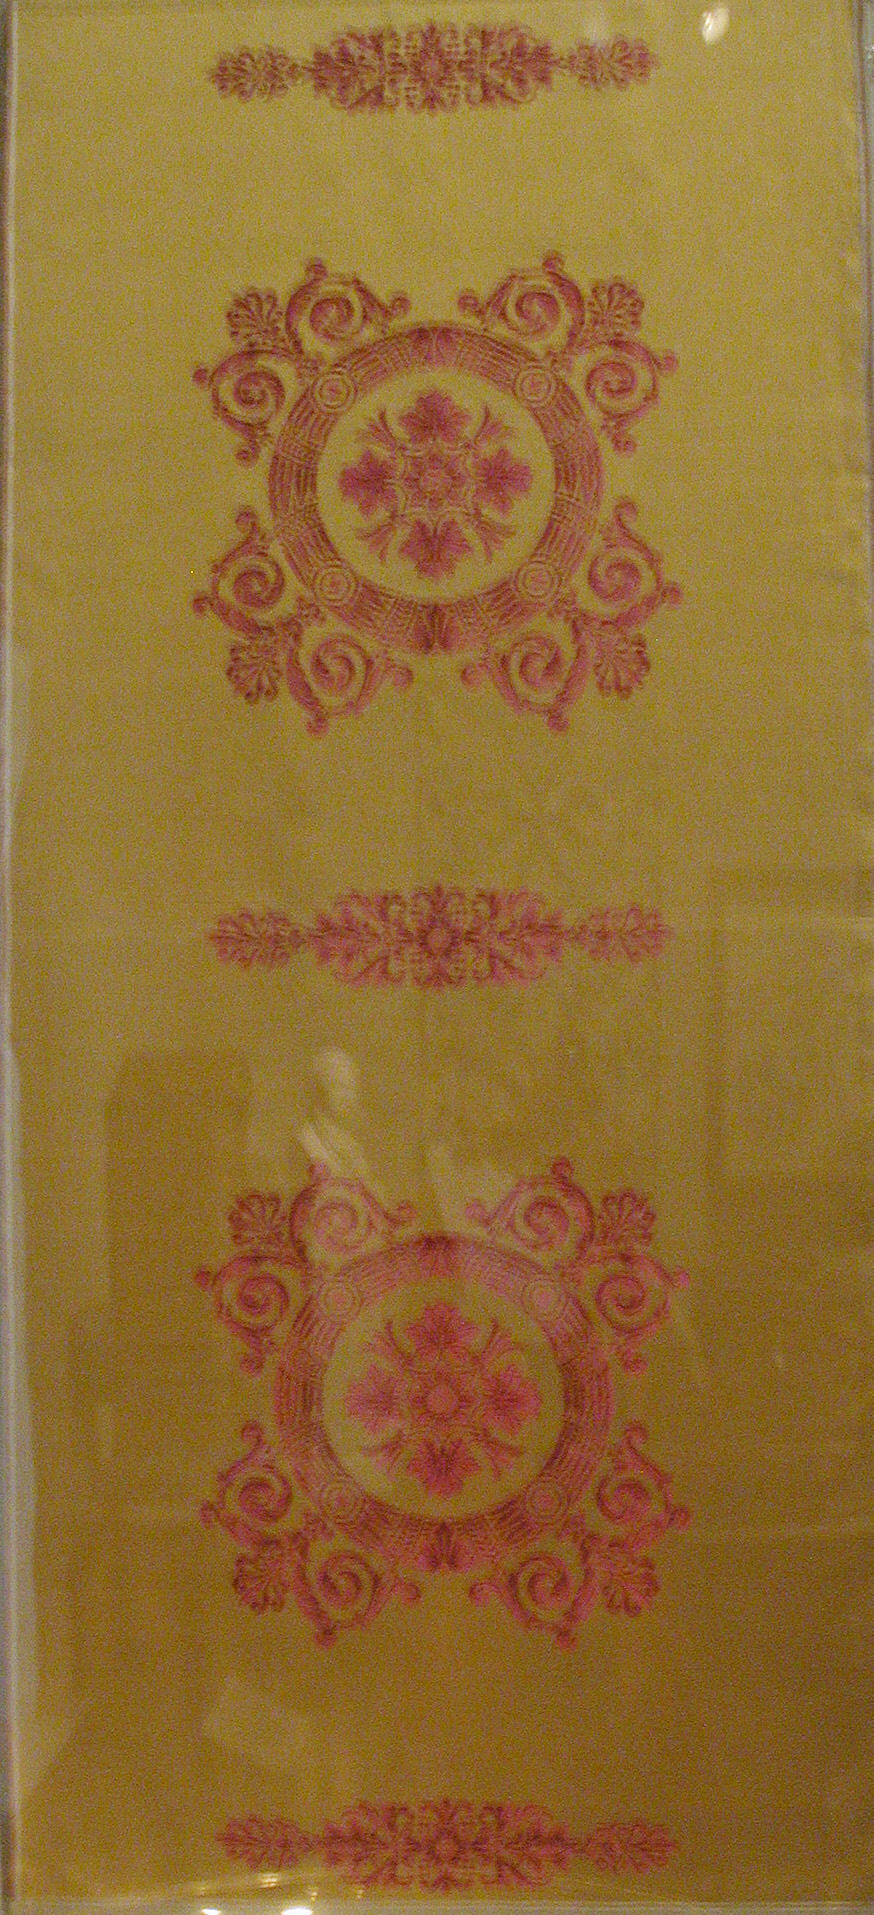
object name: length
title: Length of furnishing fabric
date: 1801-1825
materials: silk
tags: flowers